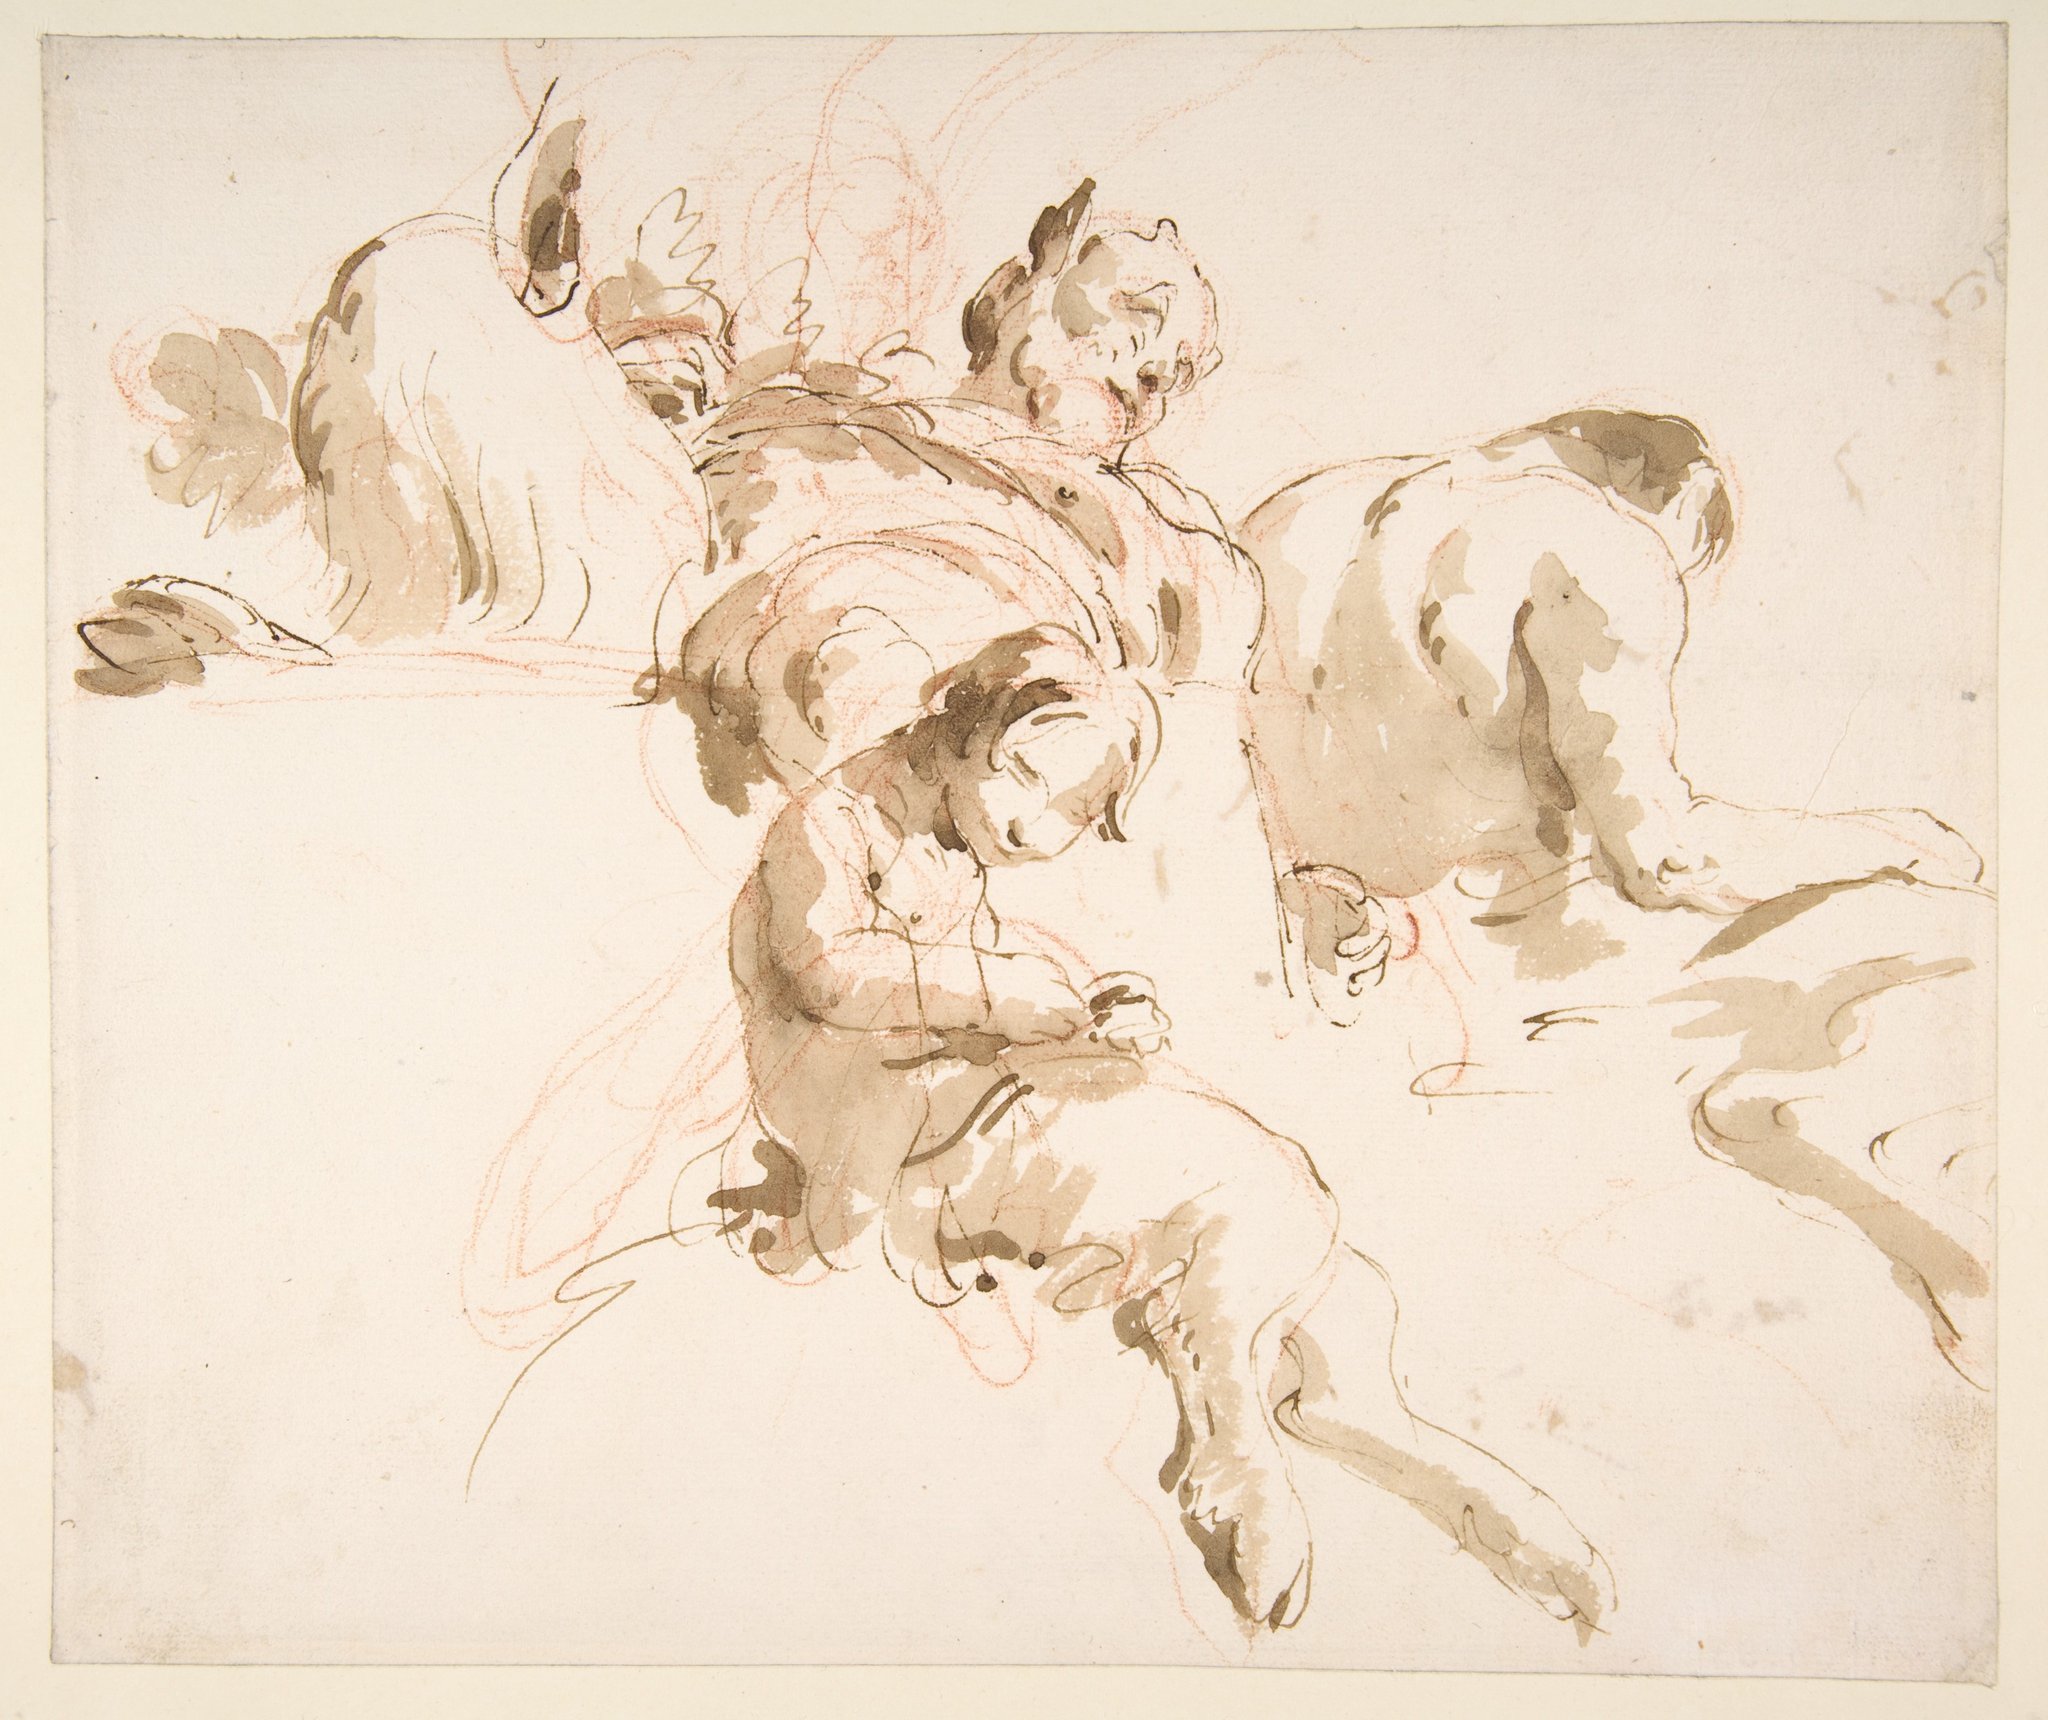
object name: drawing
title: Two Seated Satyrs and a Child Satyr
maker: giovanni battista tiepolo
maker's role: artist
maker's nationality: italian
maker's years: 1696-1770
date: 1696-1770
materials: chalk, ink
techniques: brush, pen, wash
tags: satyrs